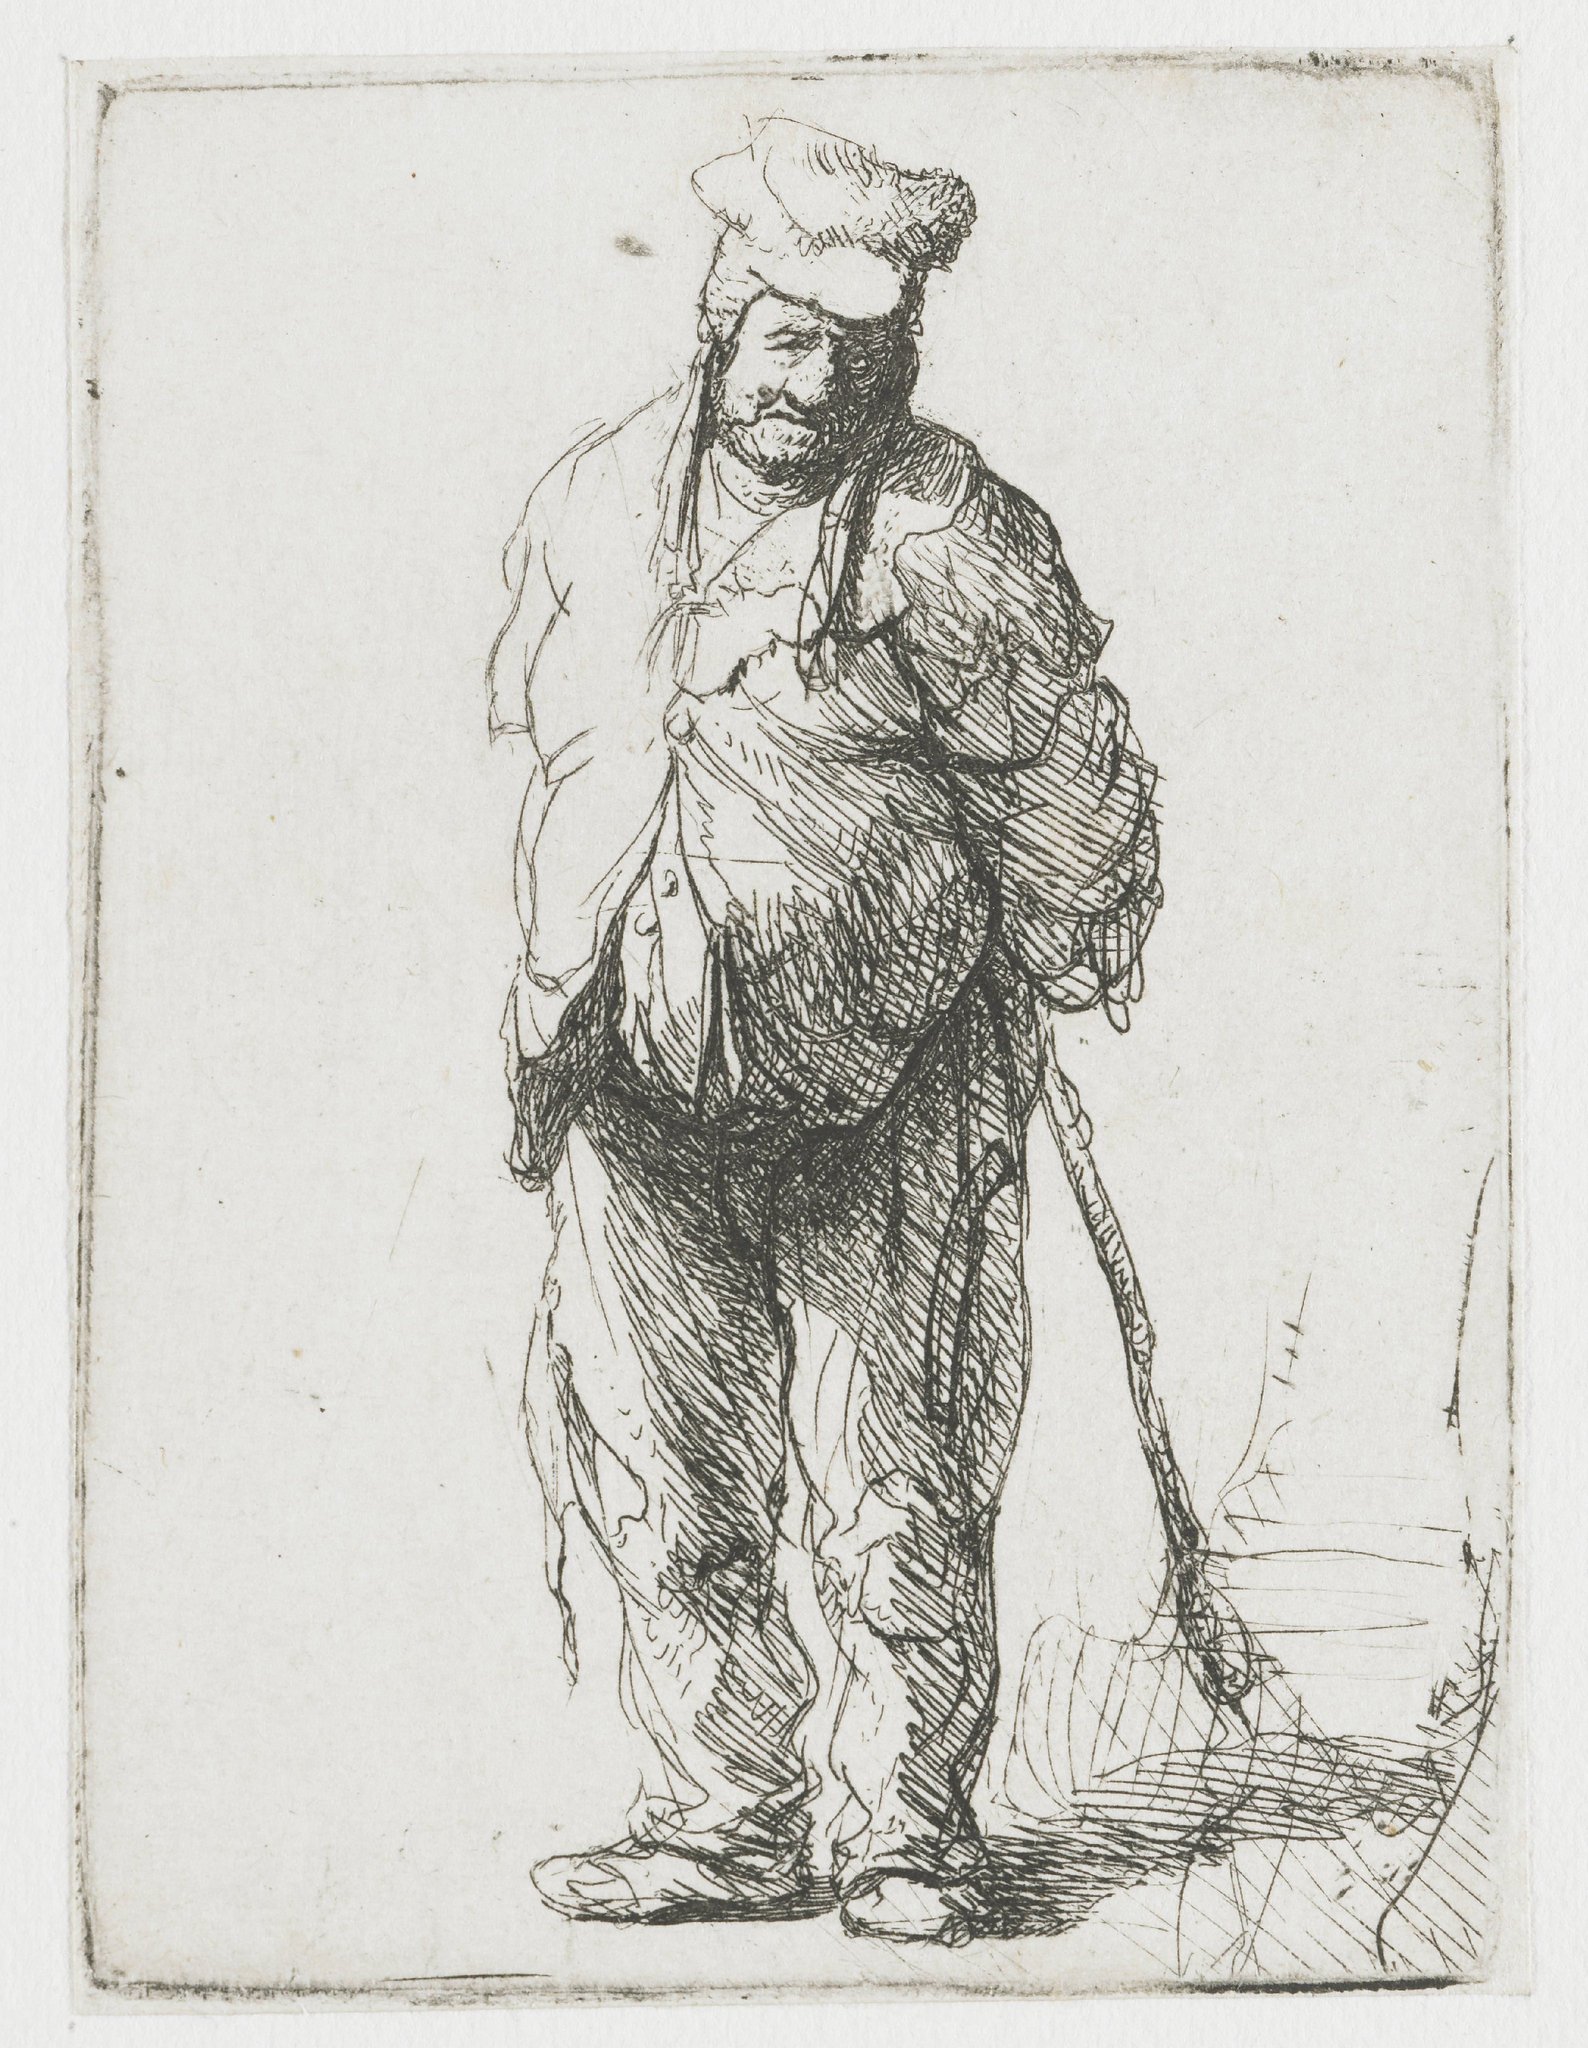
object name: print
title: Ragged peasant with his hands behind him, holding a stick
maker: rembrandt van rijn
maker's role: draughtsman, painter, print maker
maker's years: 1606-1669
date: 1630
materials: paper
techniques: drypoint, etching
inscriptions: mark: Lugt 2228 a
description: Rembrandt derived much inspiration from the figures he came across outdoors. However, he did not etch out on the street. He produced his prints indoors, in his workshop. His observations are no less telling for that fact. Both the beggar couple and the poor wretch with the wooden leg seem to be calling out loud, while the peasant in the middle looks on expectantly.